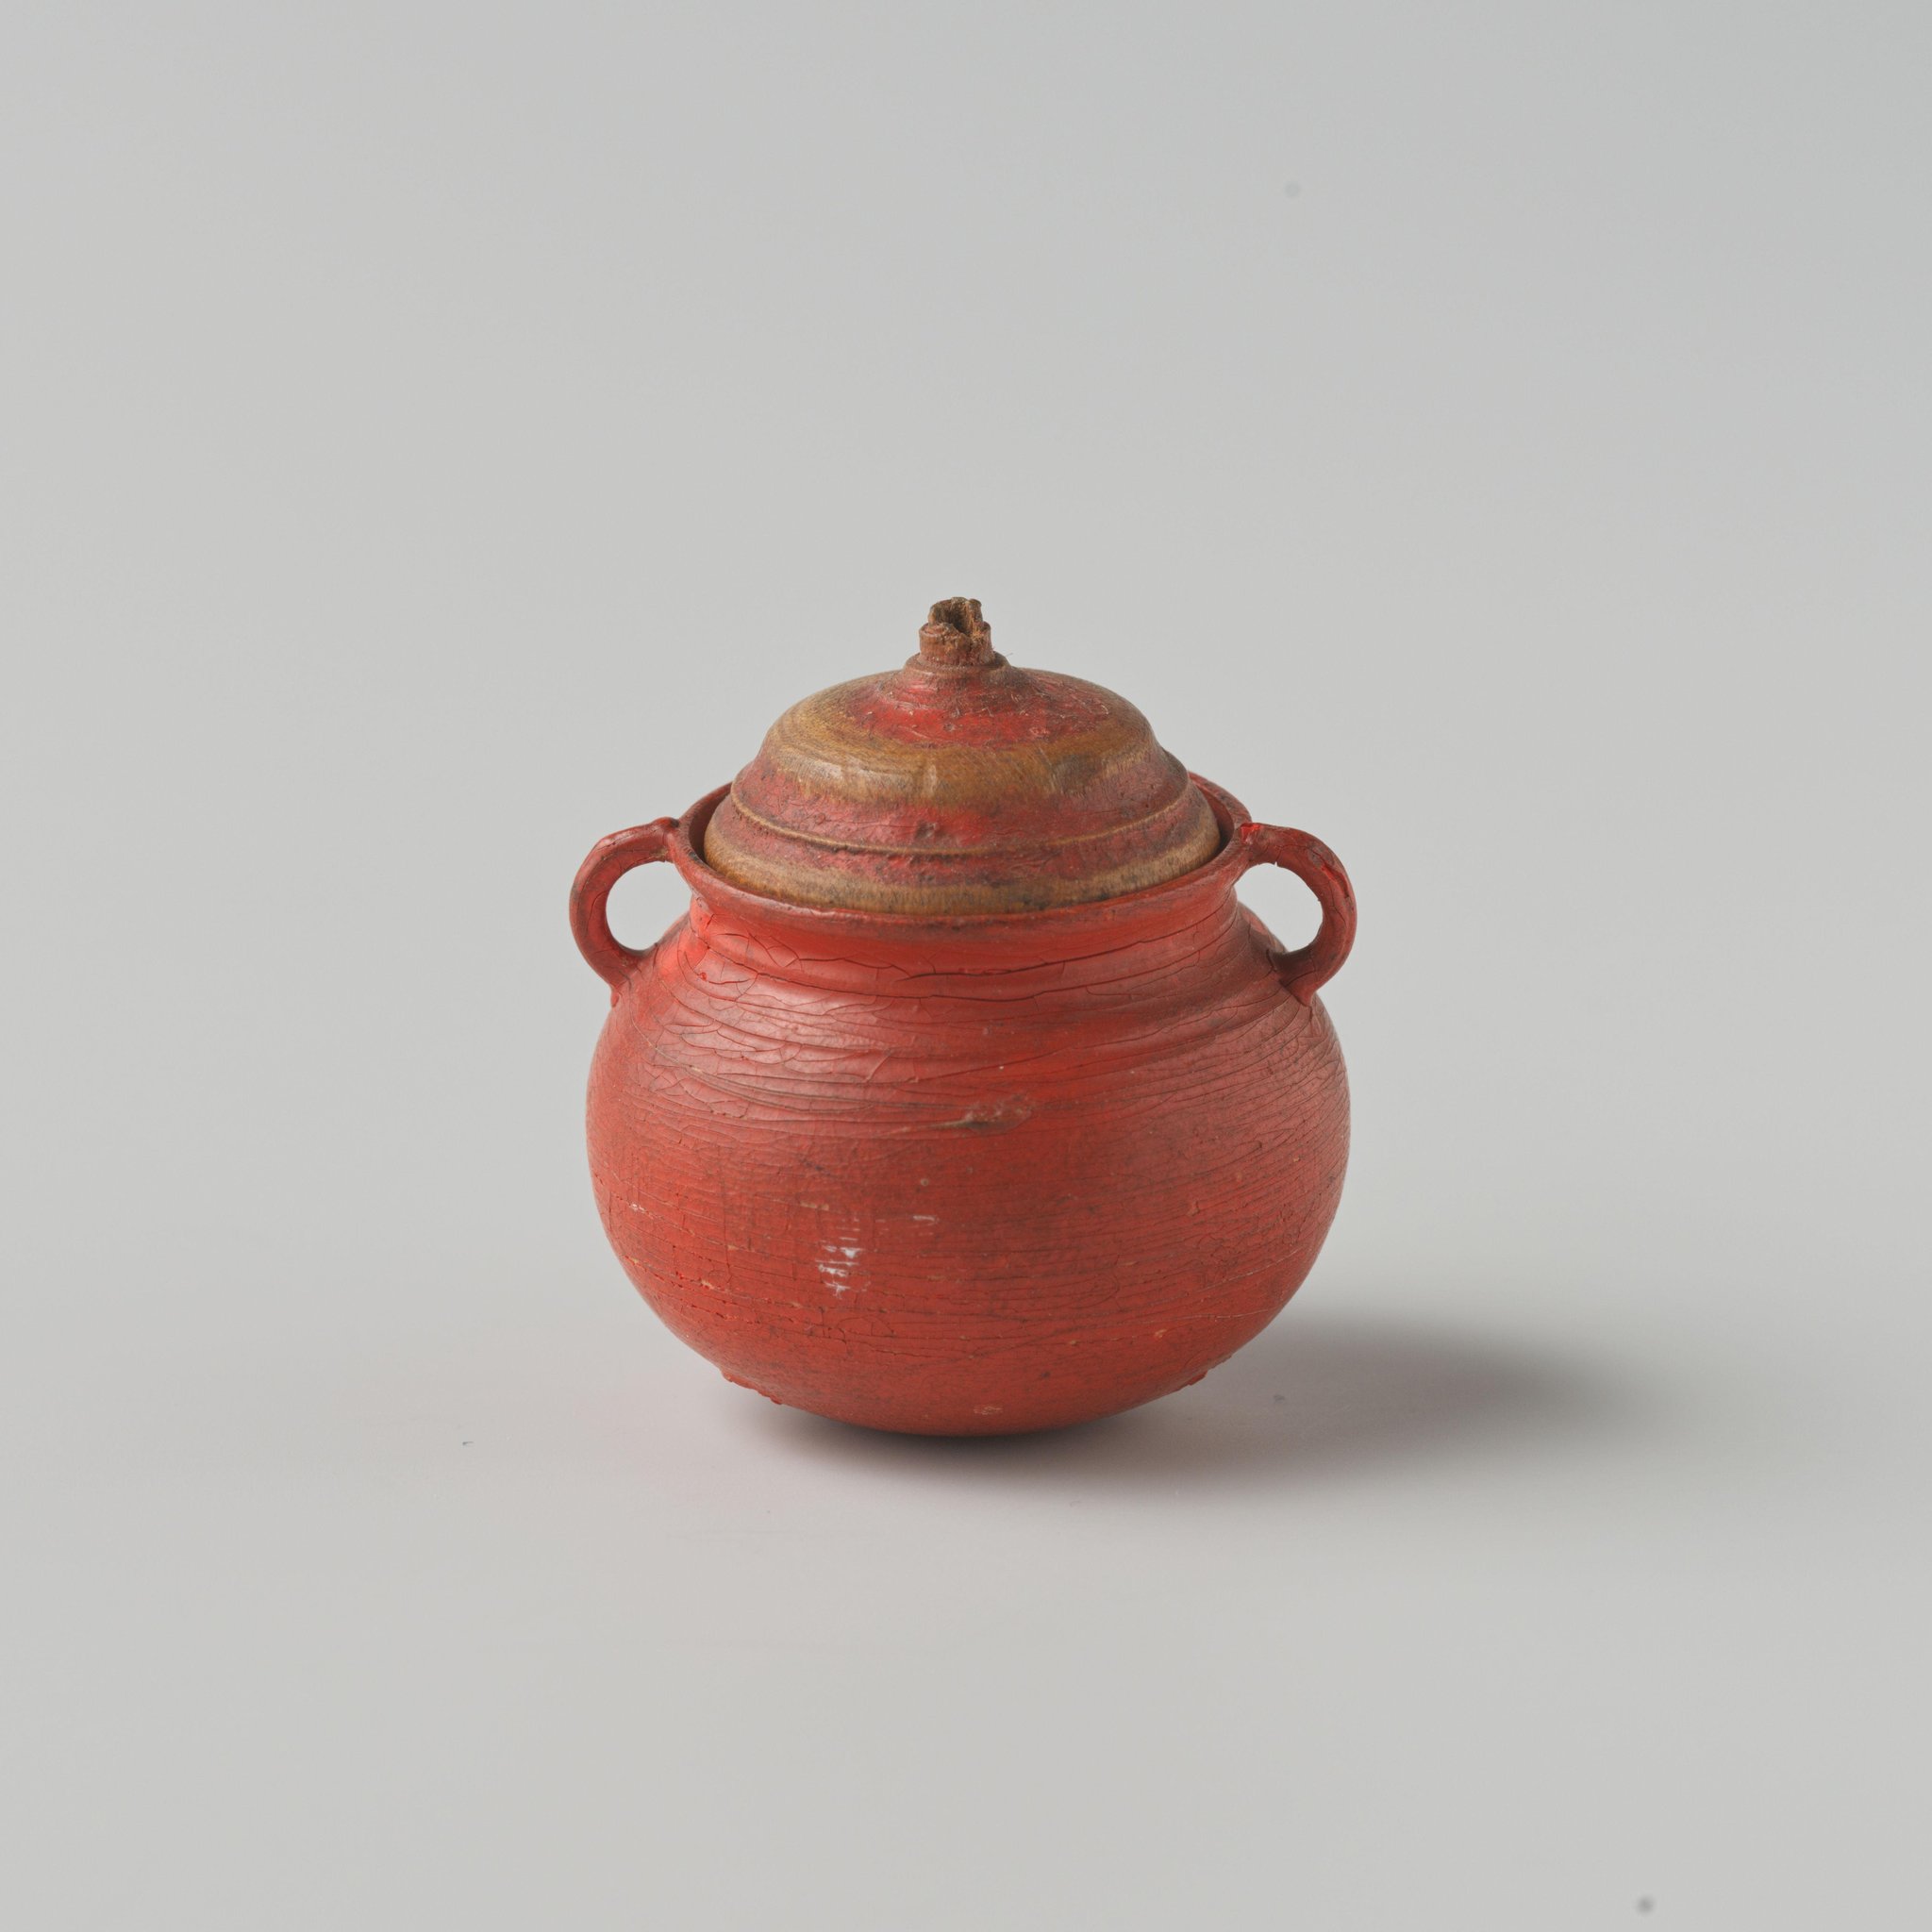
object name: pot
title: Kookpot van rood gelakt hout; met twee oren, losse deksel met (afgebroken) knop; oorspronkelijk stond de pot op drie pootjes (verdwenen).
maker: Anonymous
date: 1675-1710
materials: wood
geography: amsterdam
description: Kookpot van rond gelakt hout, met twee oren, losse deksel met (afgebroken) knop; oorspronkelijk stond de pot op drie pootjes (verdwenen).